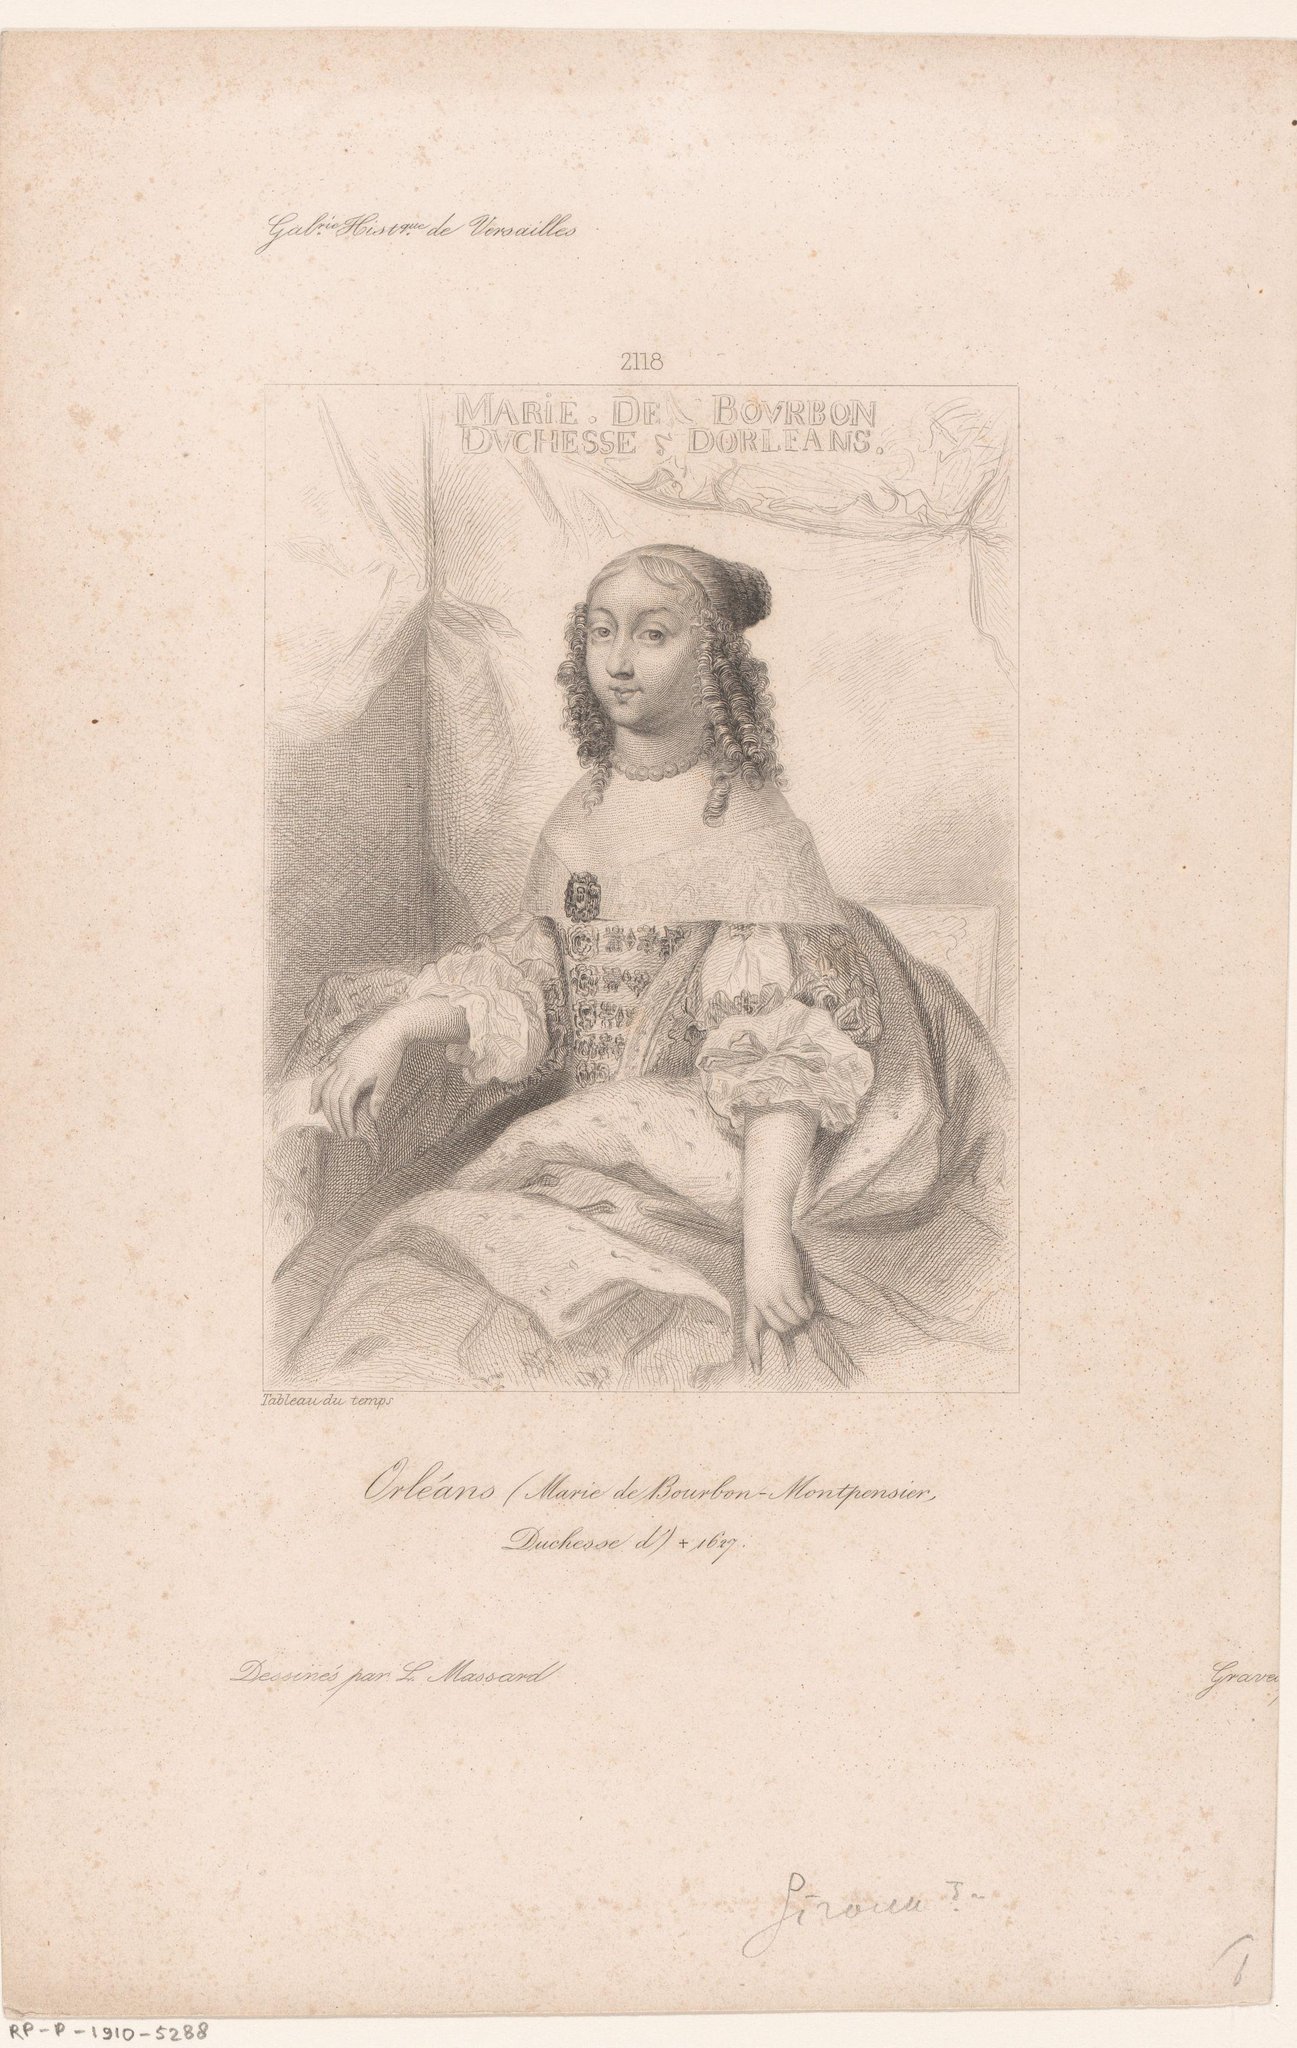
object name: print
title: Marie d'Orléans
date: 1838-1841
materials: paper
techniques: engraving, etching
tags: historical persons, princess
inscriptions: collector's mark: Lugt 2228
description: Prent uit: Galeries historiques de Versailles. Parijs: Charles Gavard, 1838-1841.